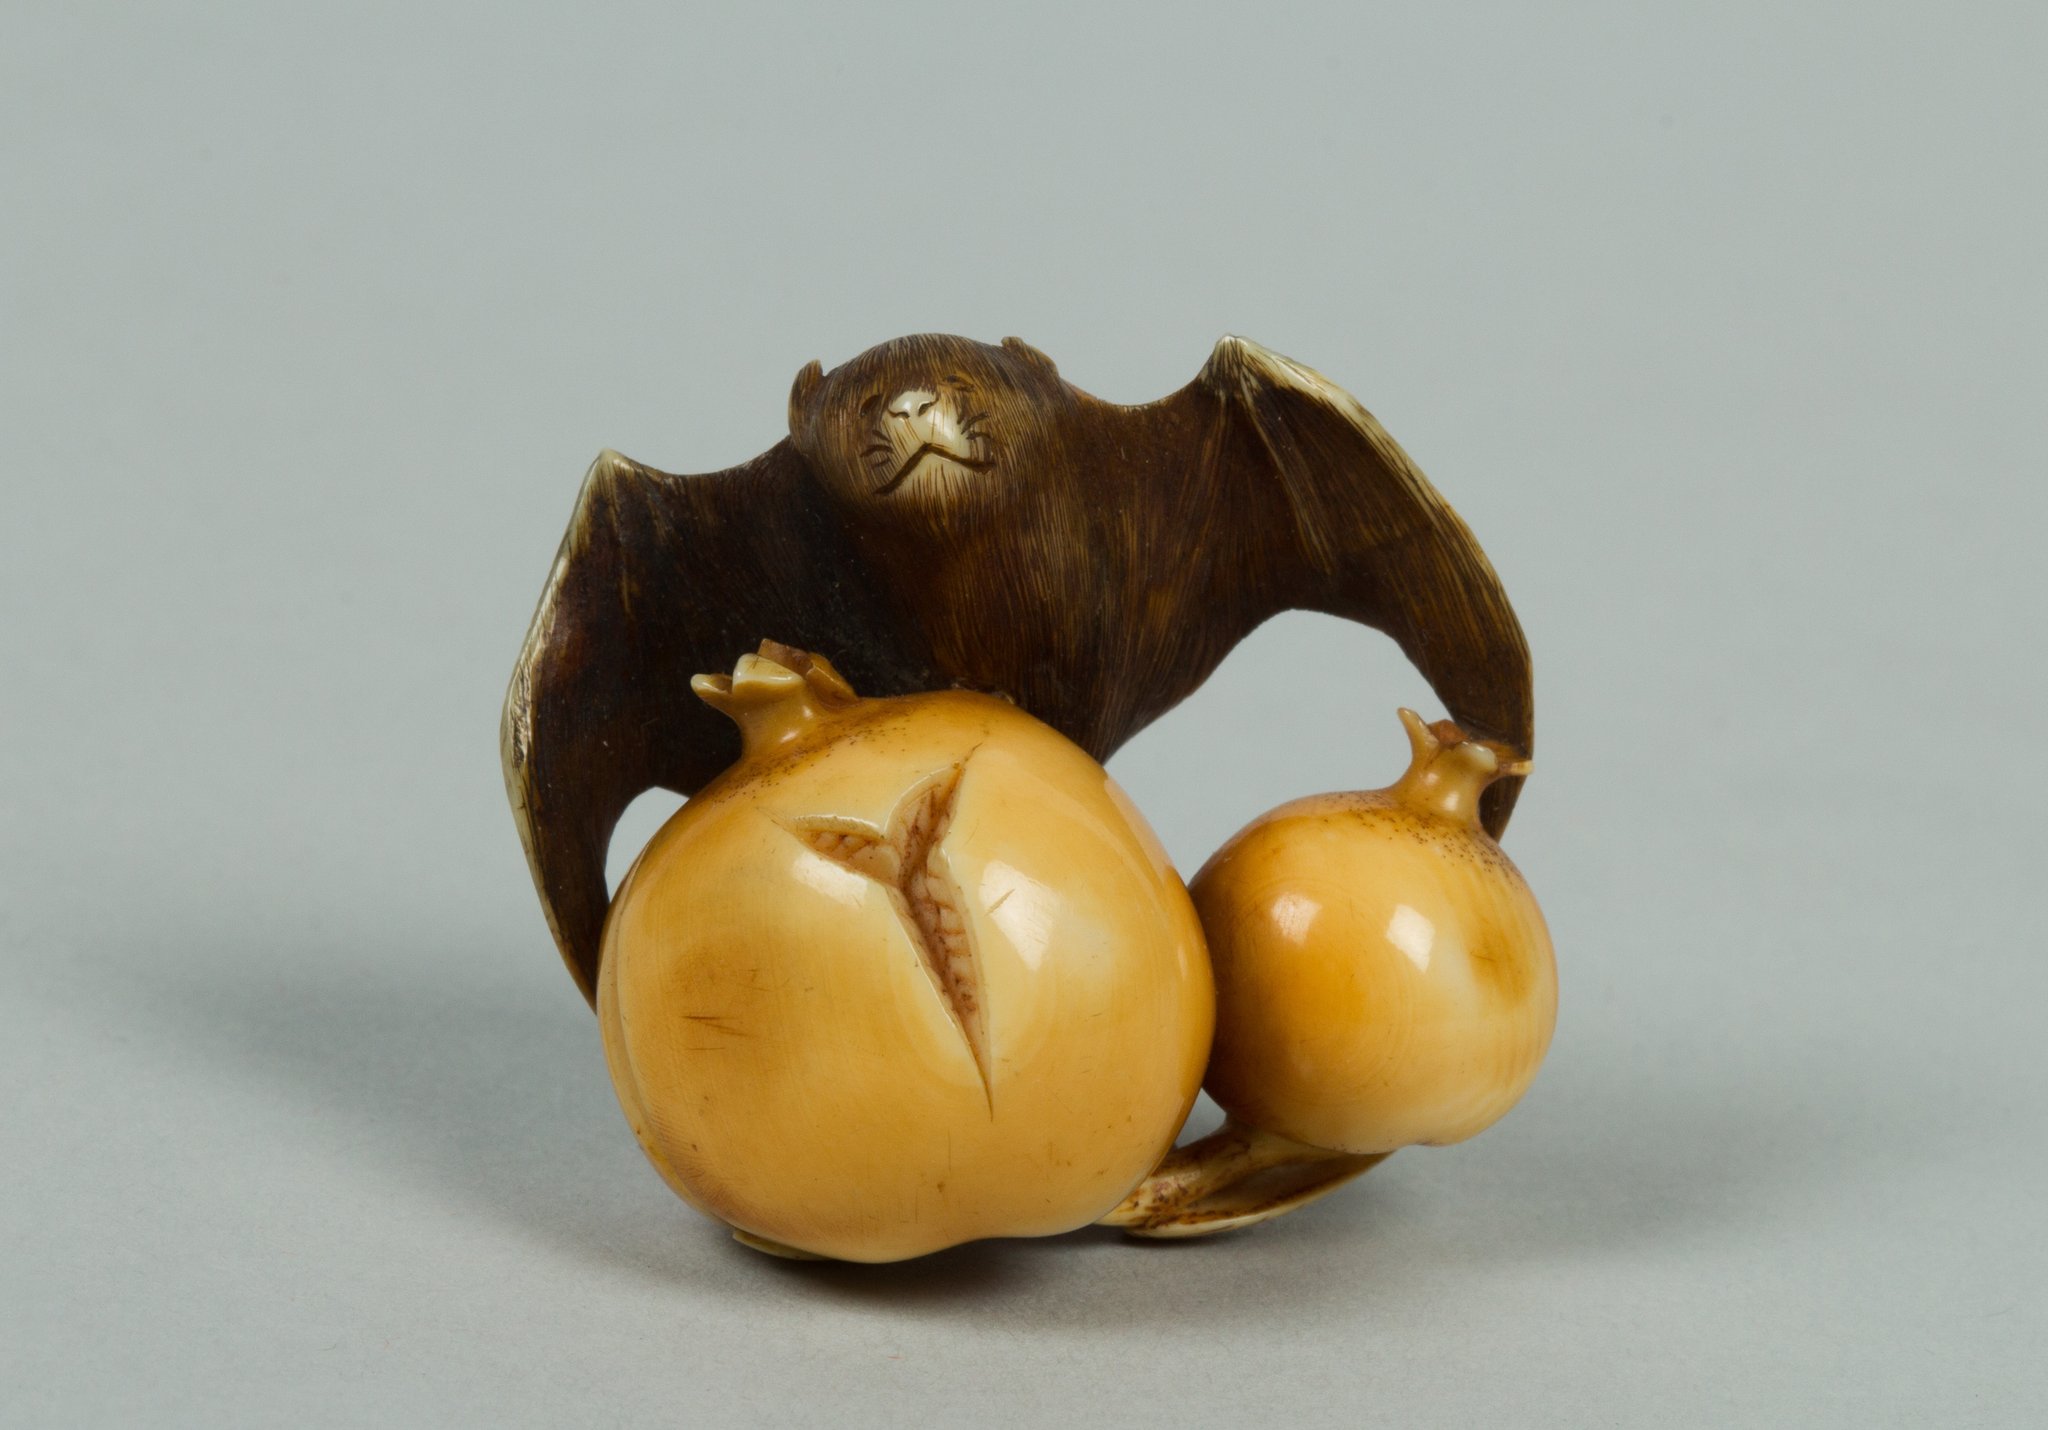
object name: netsuke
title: Netsuke of Bat and Fruit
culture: japanese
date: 1801-1900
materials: ivory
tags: pomegranates